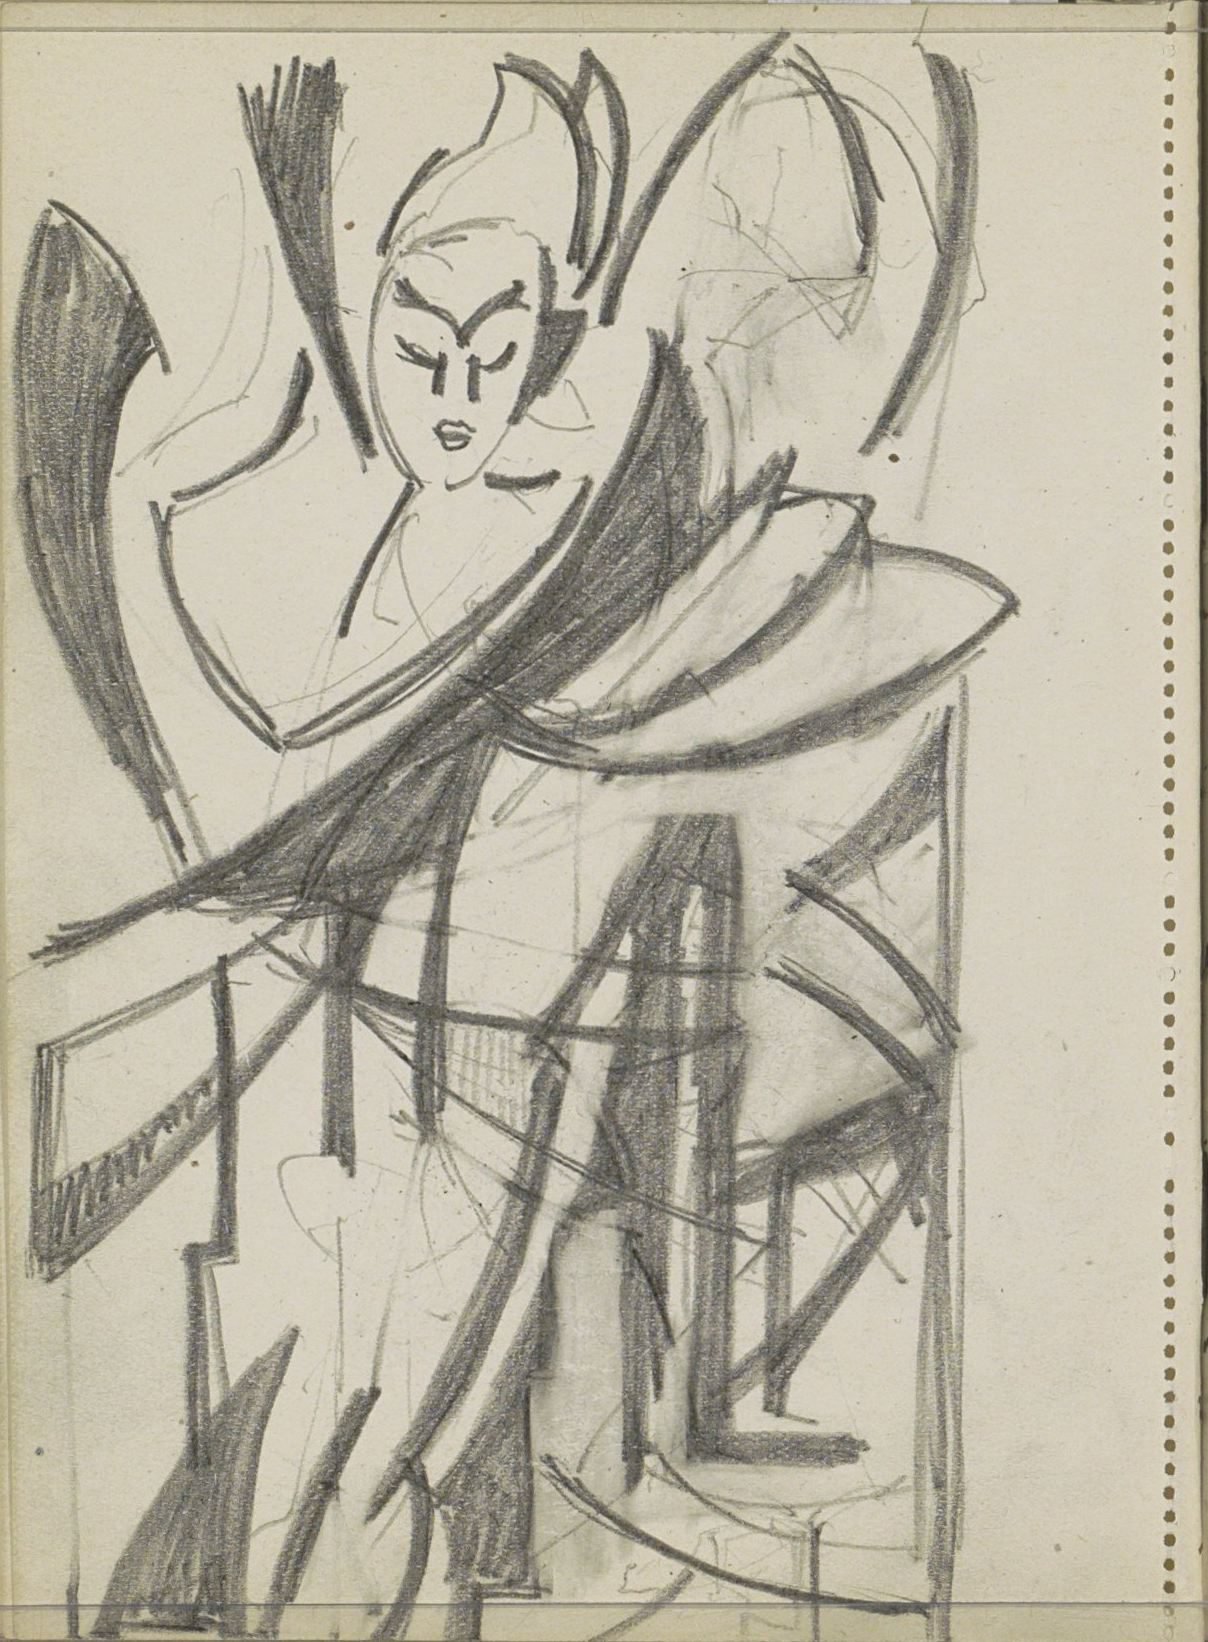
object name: sketchbook leaf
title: Danseres in traditioneel kostuum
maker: reijer stolk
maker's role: draughtsman, print maker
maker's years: 1896-1945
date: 1906-1945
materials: paper, pencil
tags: woman dancing alone, folk costume, regional costume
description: Mogelijk een Javaanse danseres. Blad 16 verso uit een schetsboek met 53 bladen.